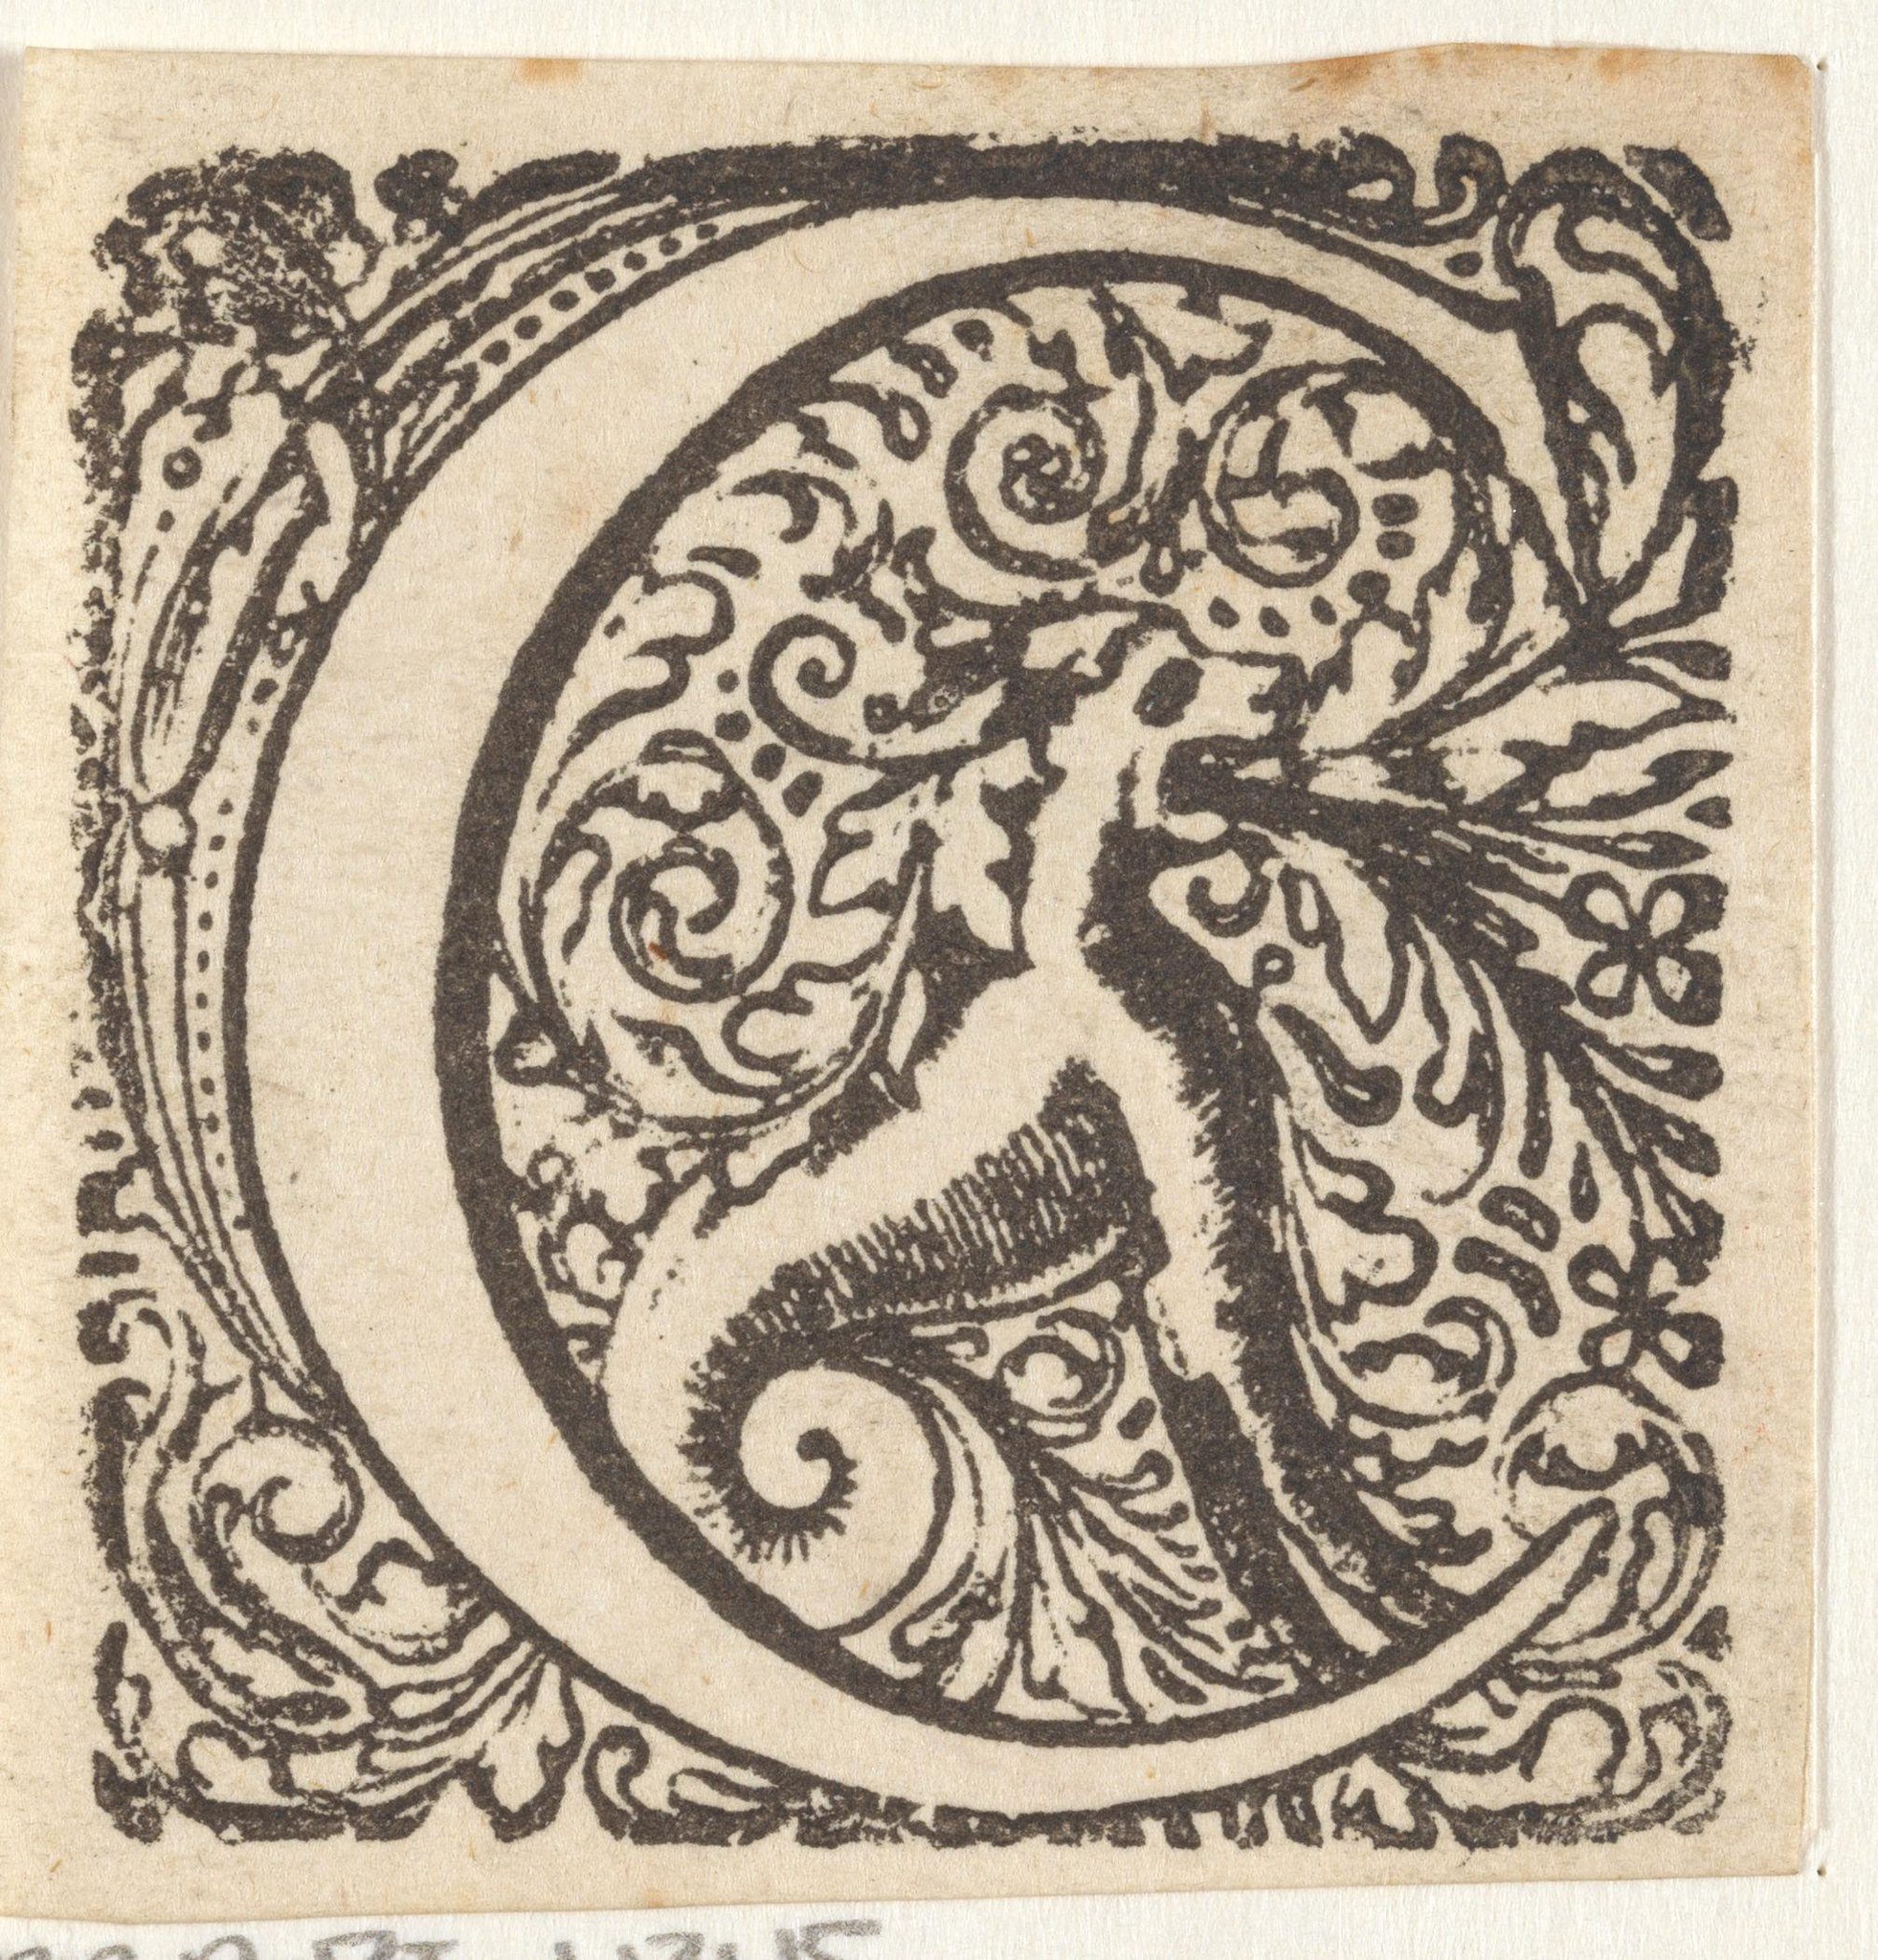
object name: print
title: Letter C in een omlijsting met een wolf of een hond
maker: Anonymous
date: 1600-1699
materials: paper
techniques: woodcut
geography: netherlands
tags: animals, fancy letters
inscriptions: collector's mark: Lugt 240